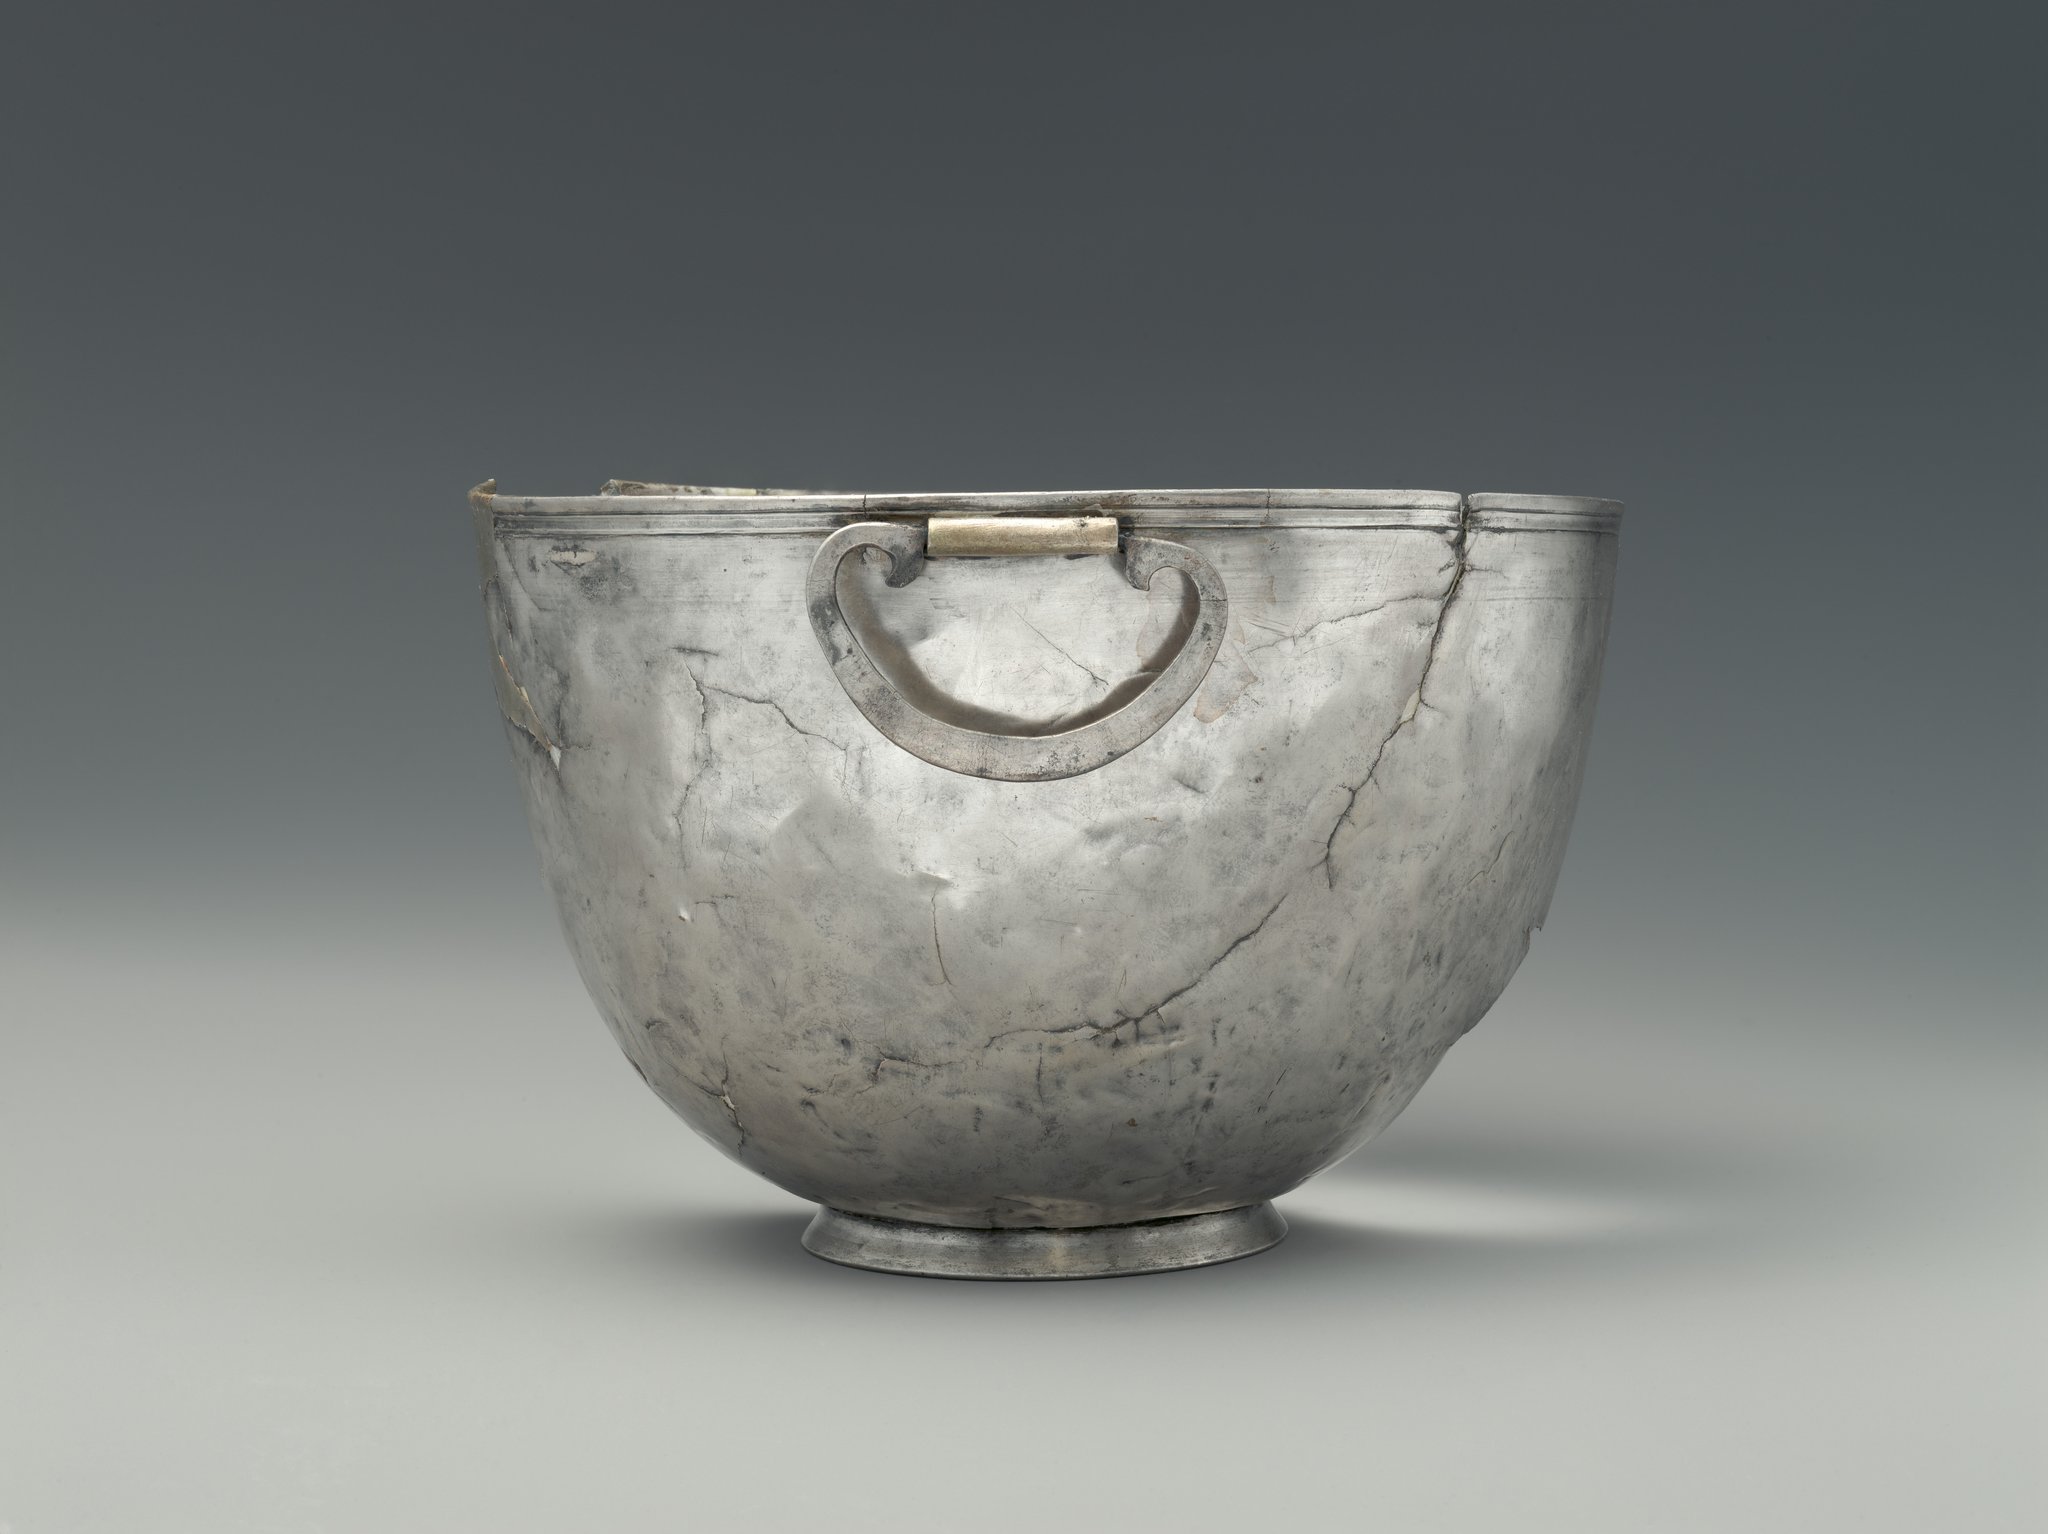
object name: handle of a bowl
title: Silver bowl with swinging handles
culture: greek or south italian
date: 334-301 BCE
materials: silver